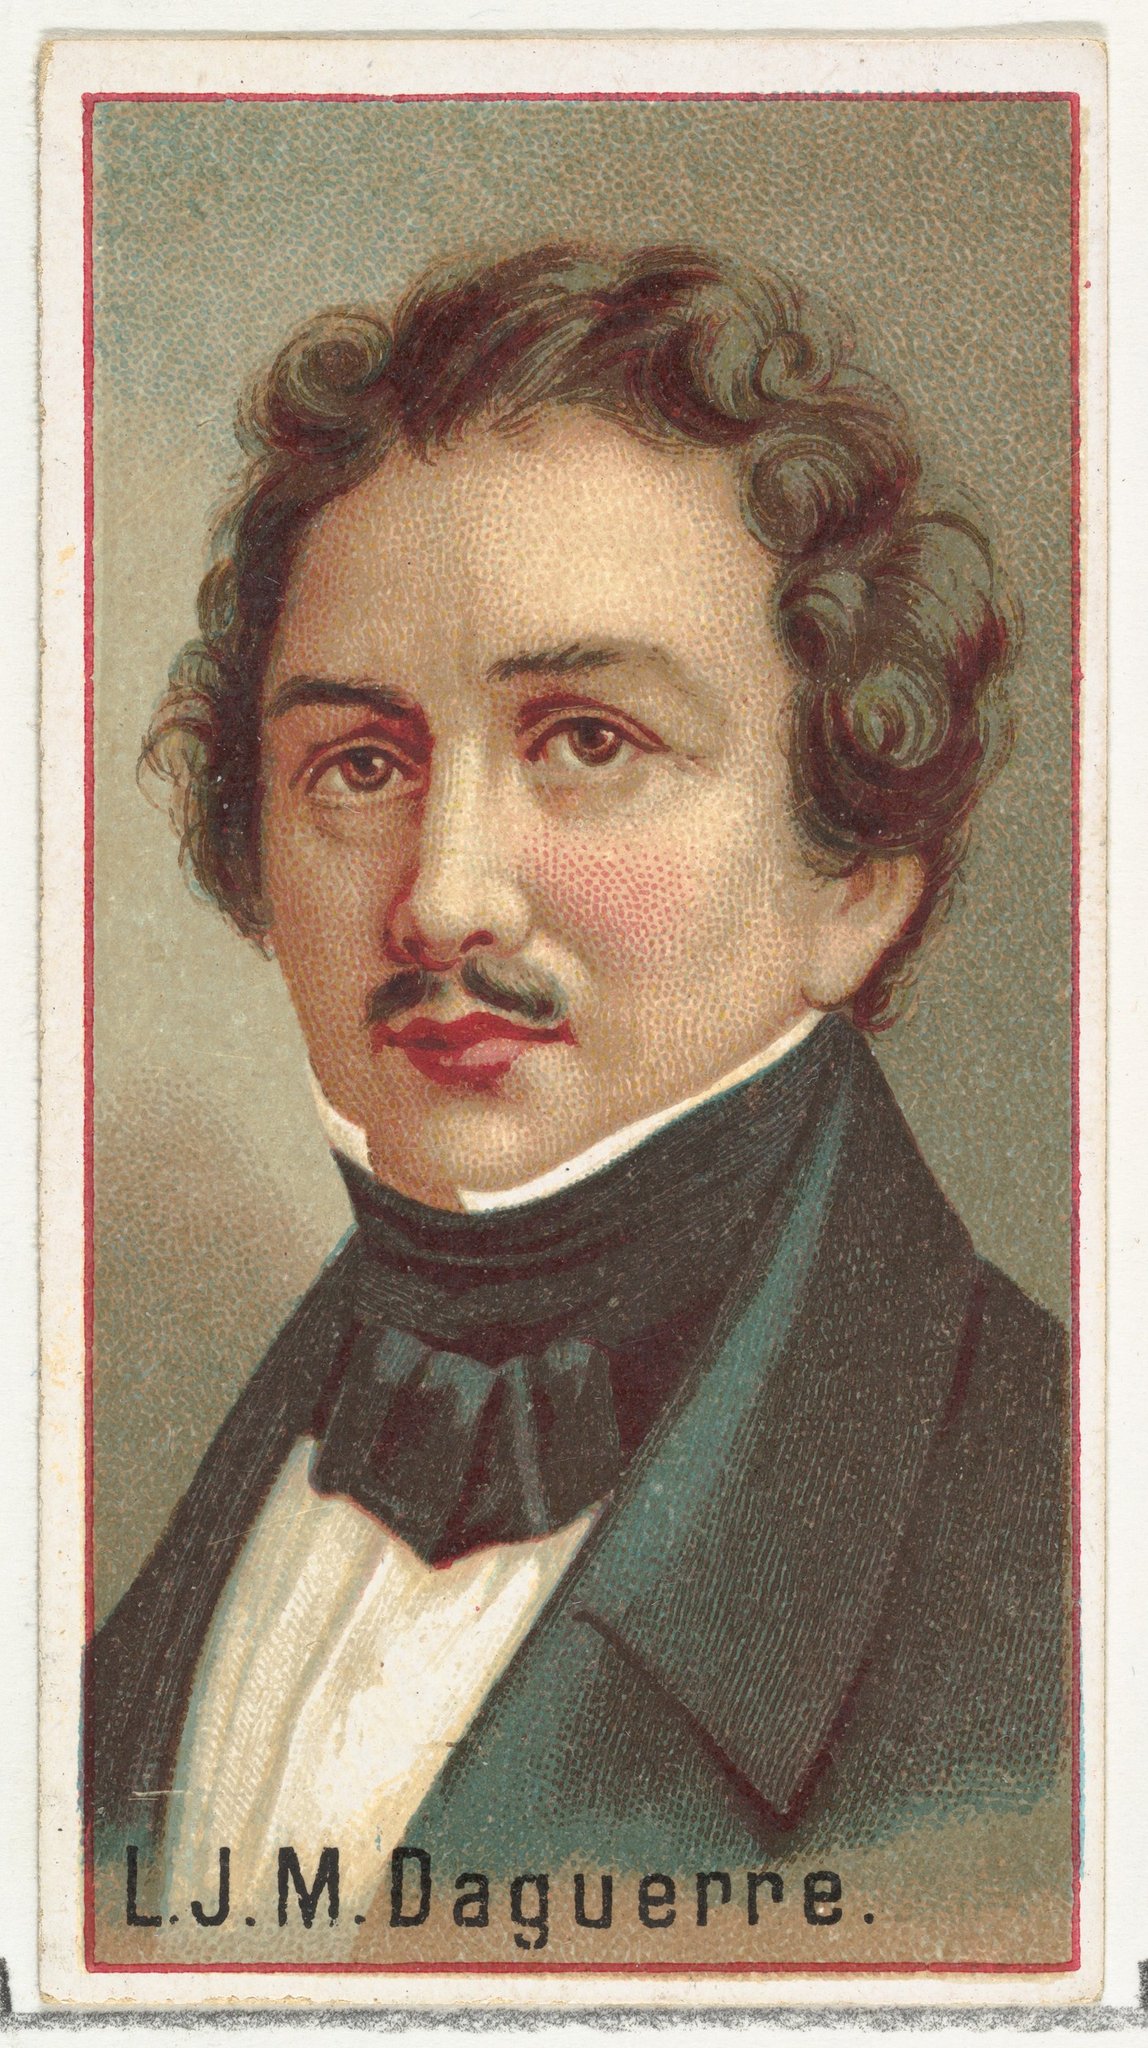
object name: print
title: L. J. M. Daguerre, printer's sample for the World's Inventors souvenir album (A25) for Allen & Ginter Cigarettes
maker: allen & ginter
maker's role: publisher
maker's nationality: american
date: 1888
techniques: color lithograph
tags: men,portraits